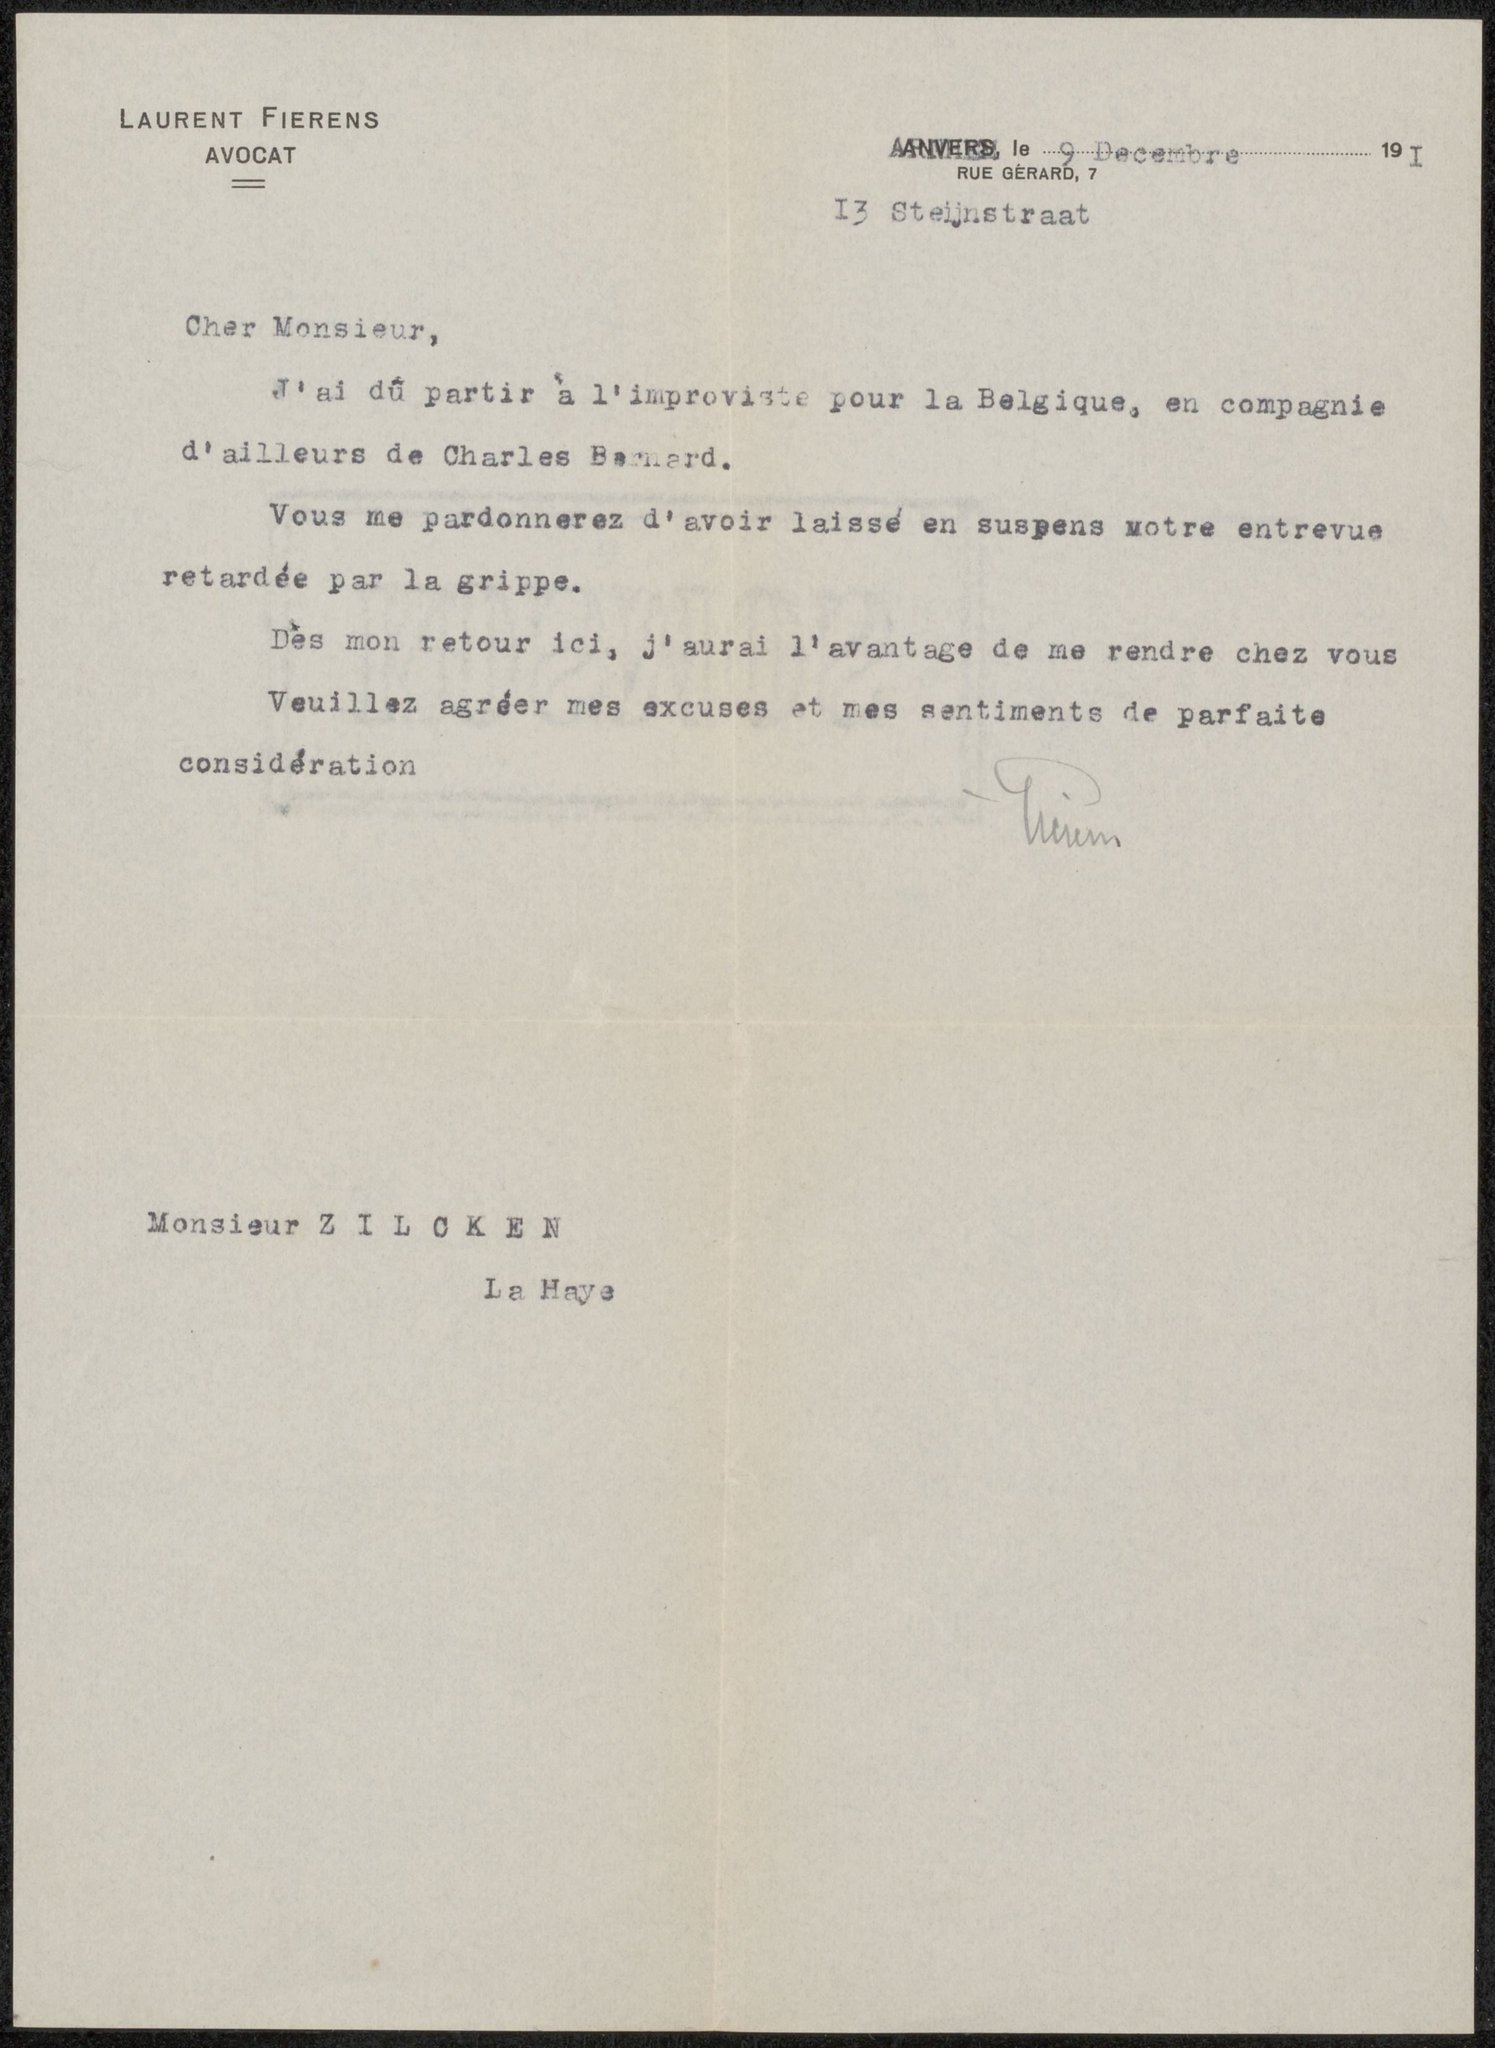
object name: letter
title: Brief aan Philip Zilcken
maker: laurent fierens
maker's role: advocaat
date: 1918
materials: ink, paper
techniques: pen, printing, typewriting, writing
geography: arnhem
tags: antwerp, brussels, the hague, painter, draughtsman, philip zilcken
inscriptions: collector's mark: ‘RPK’